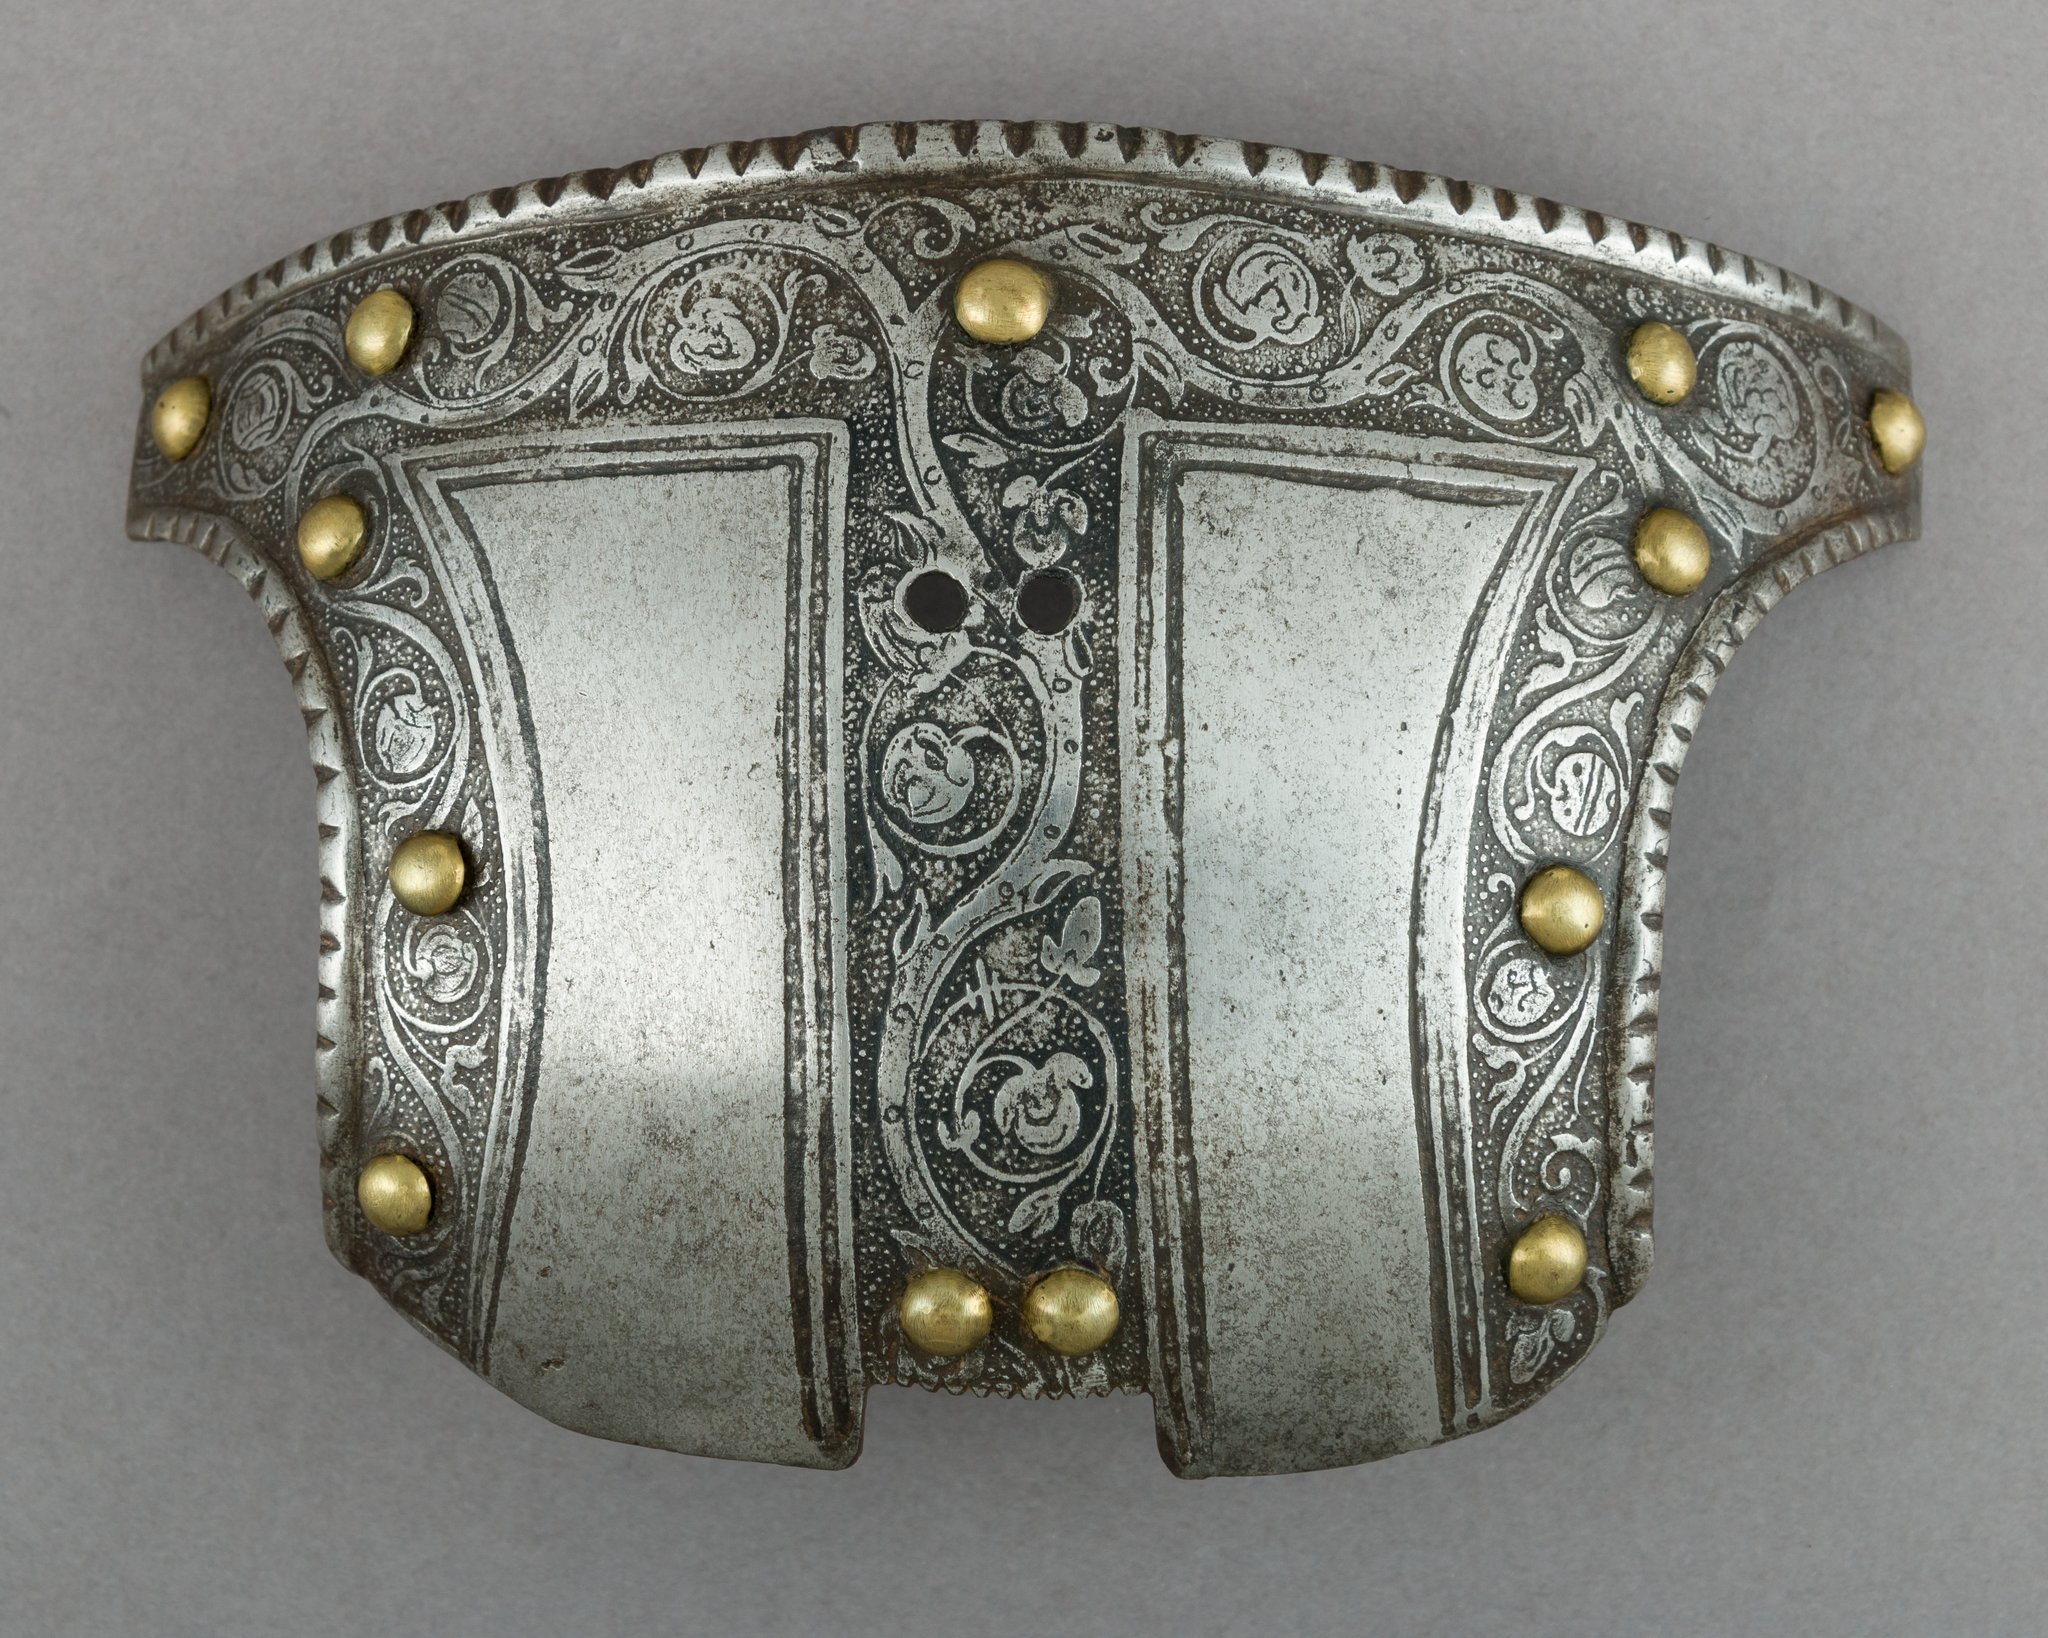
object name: shaffron horse's head defense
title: Top Half of a Shaffron (Horse's Head Defense)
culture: german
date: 1550-1560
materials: brass, steel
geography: germany